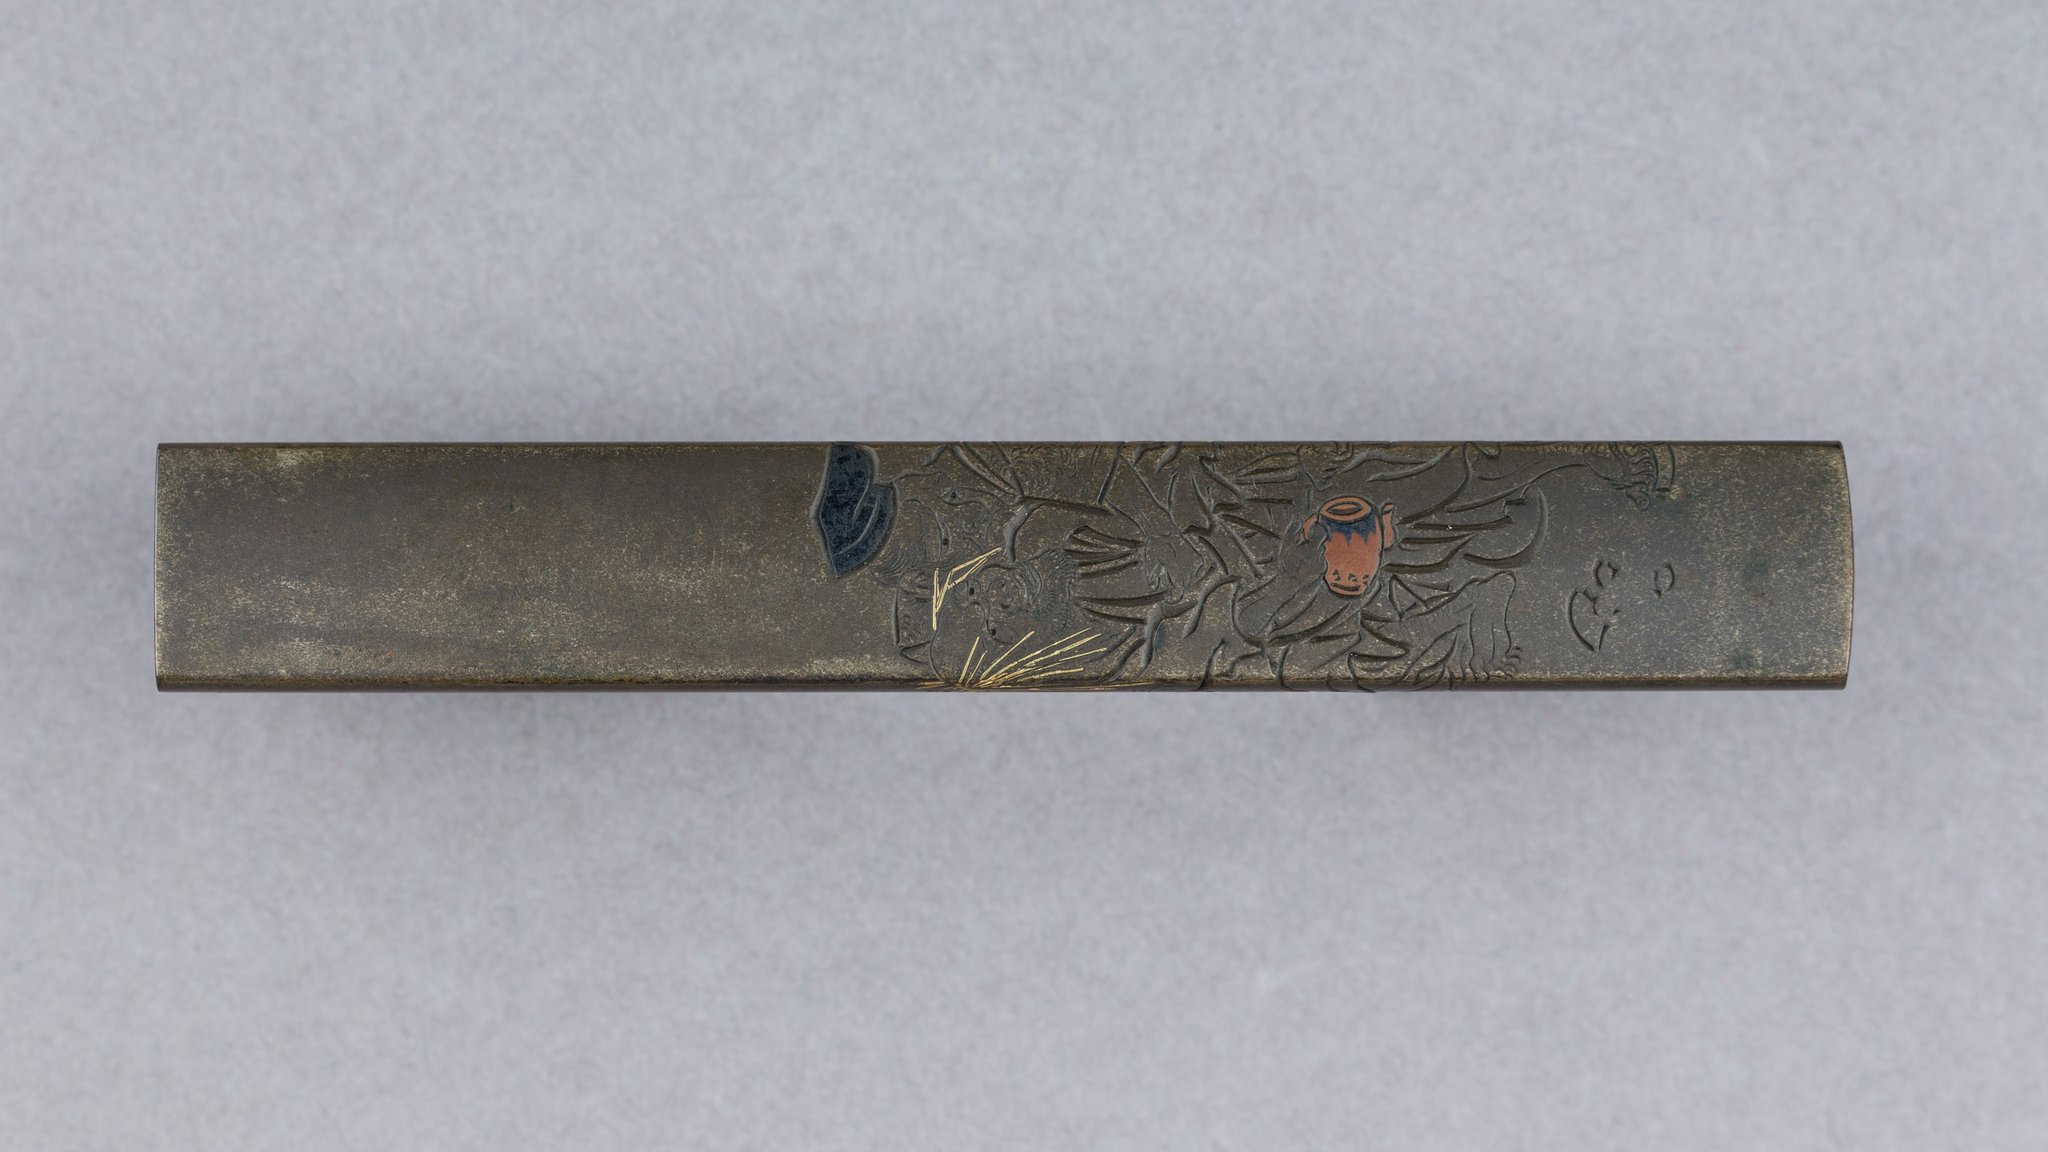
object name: knife handle kozuka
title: Knife Handle (Kozuka)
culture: japanese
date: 1701-1800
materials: copper, gold alloy, silver alloy, gold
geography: japan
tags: men